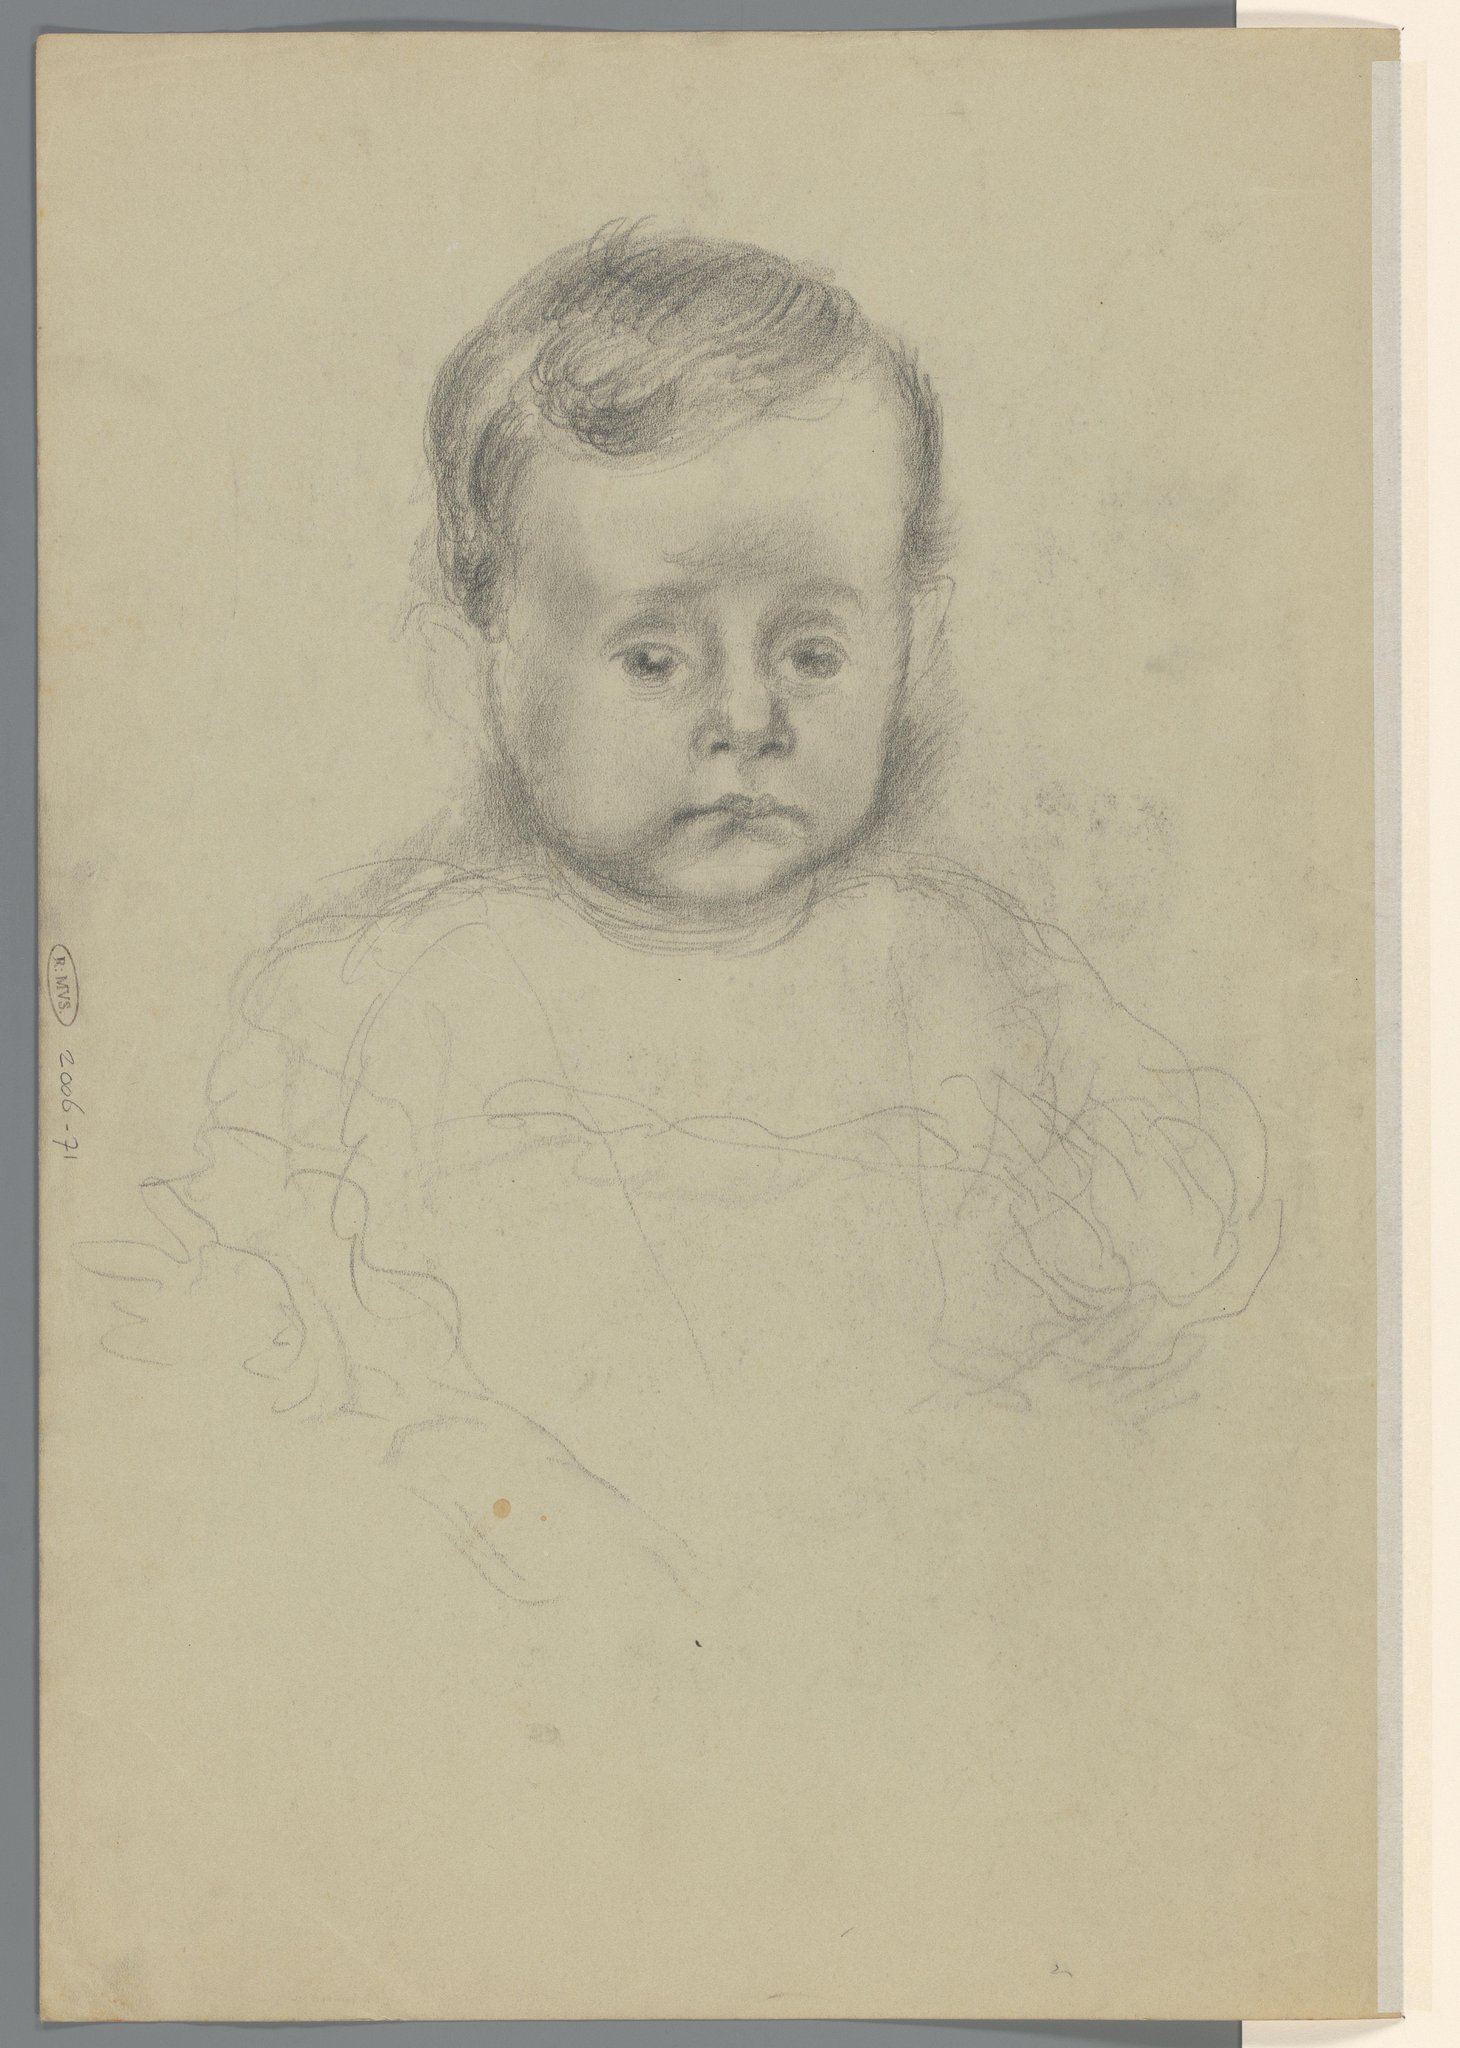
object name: drawing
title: Baby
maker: henk henriët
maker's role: draughtsman, print maker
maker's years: 1903-1945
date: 1913-1945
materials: chalk, paper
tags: infant, baby